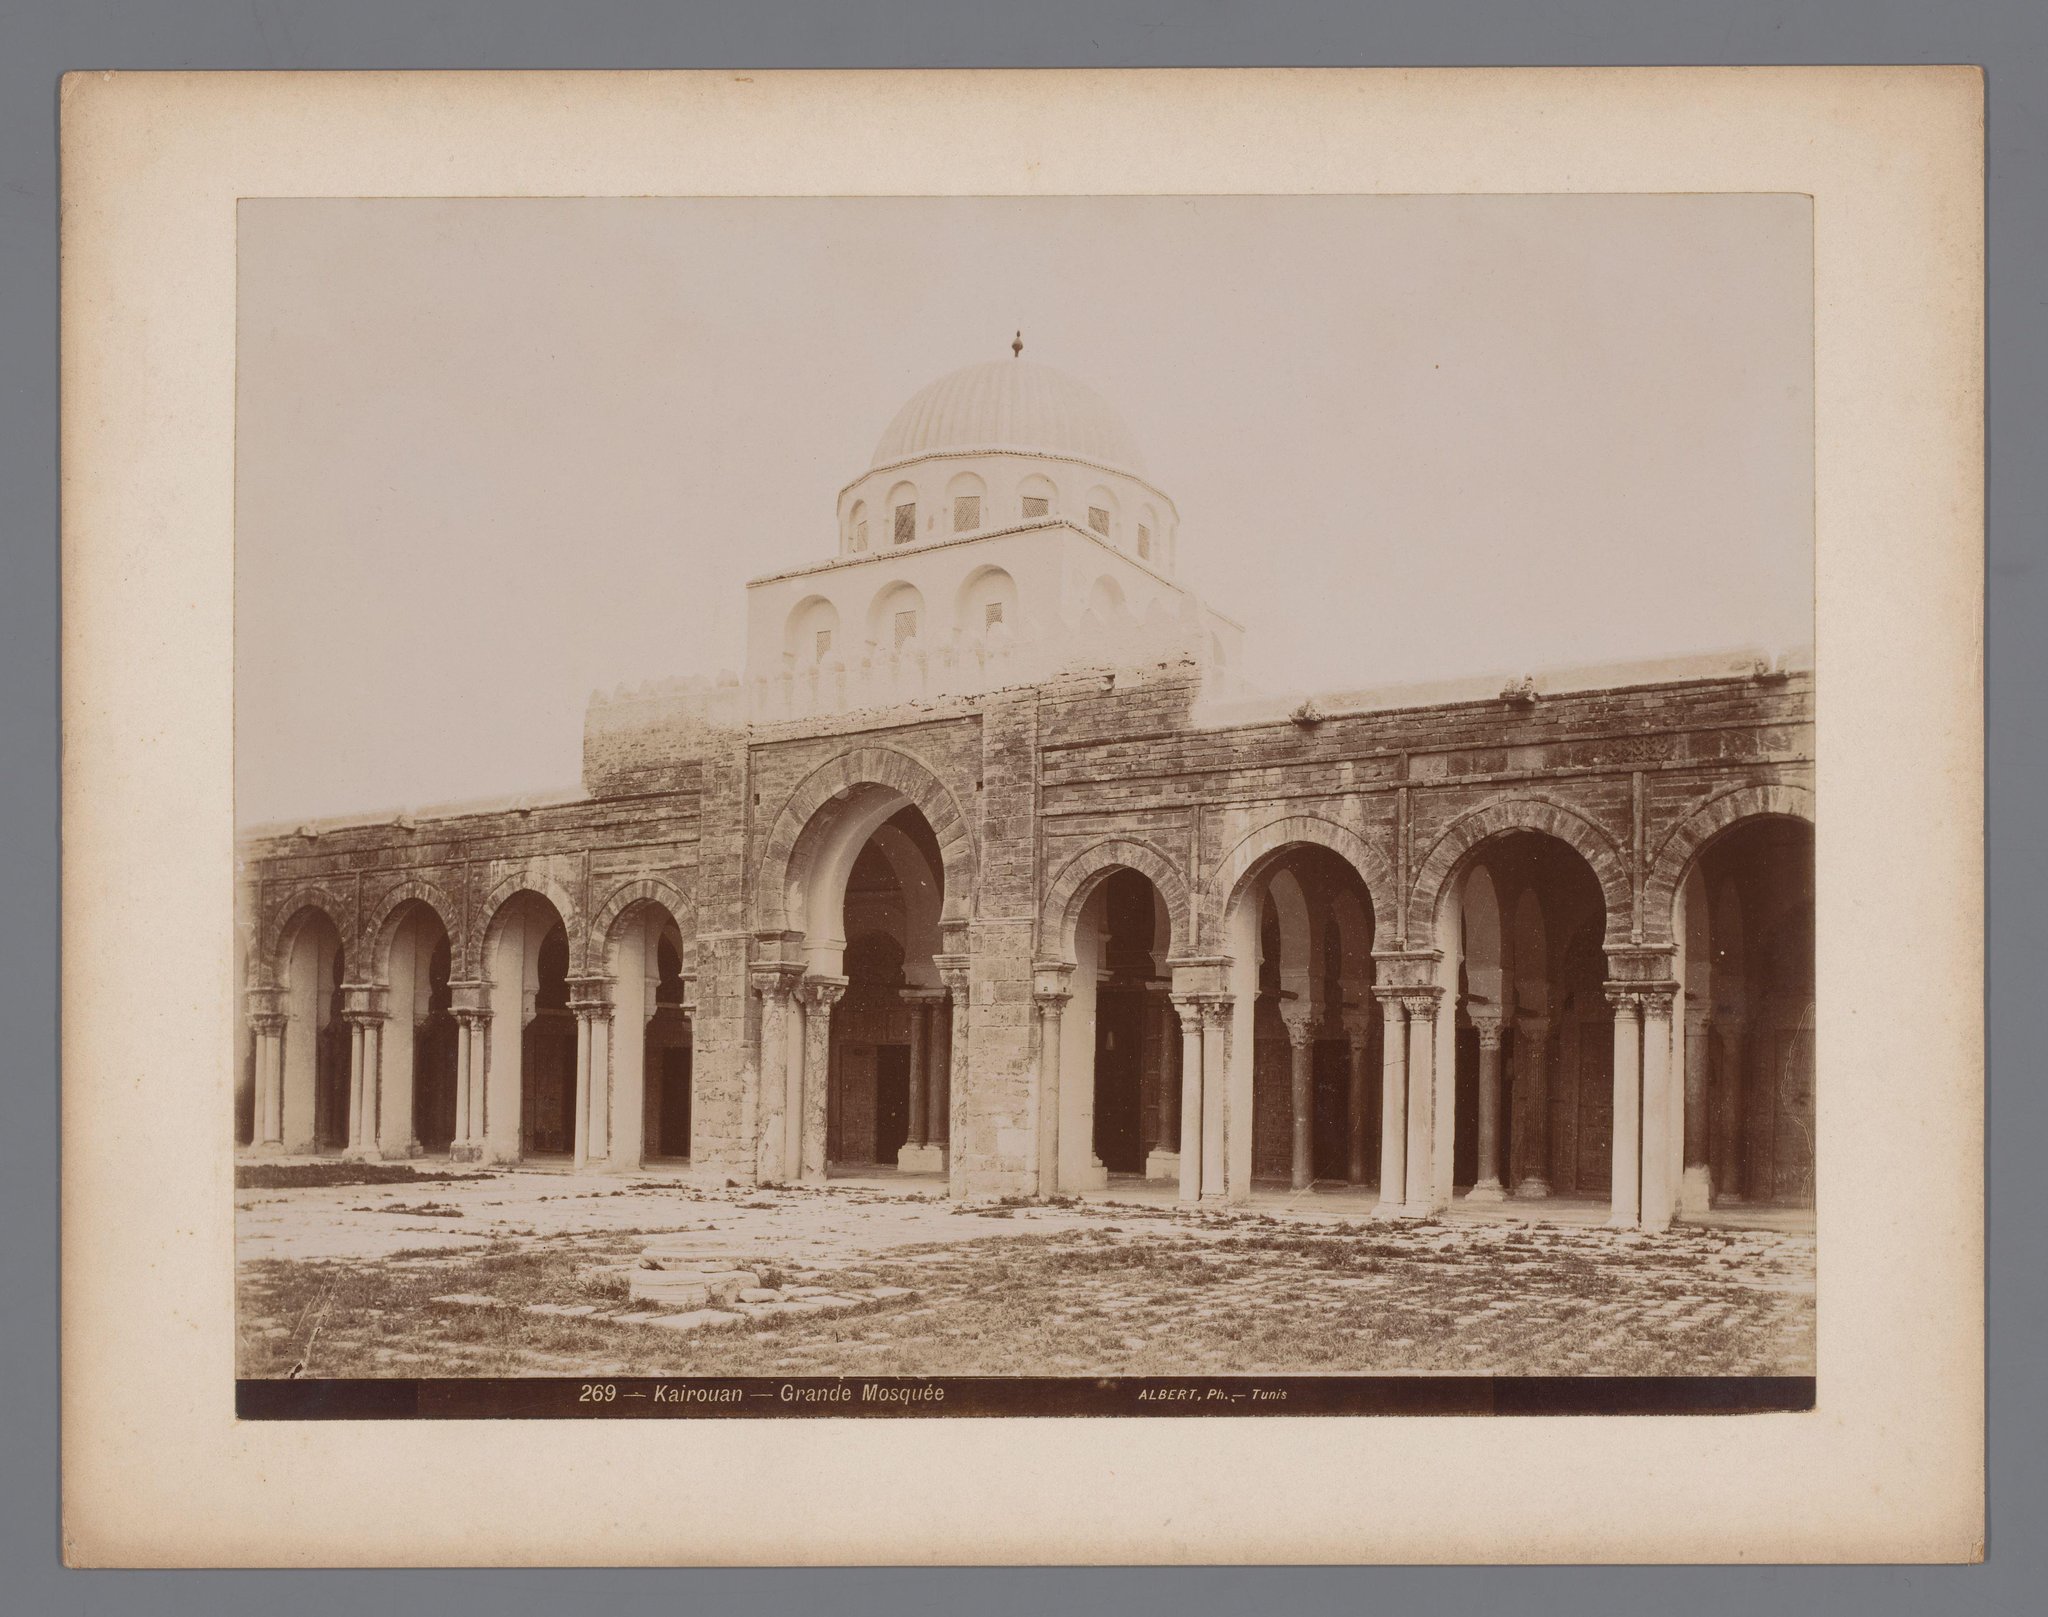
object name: photograph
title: Grote moskee van Kairouan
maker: albert goupil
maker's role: publisher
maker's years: 1840-1884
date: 1860-1900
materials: cardboard, paper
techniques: albumen print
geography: kairouan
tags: temple, shrine ~ islam, mohammedanism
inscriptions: number: ‘269’